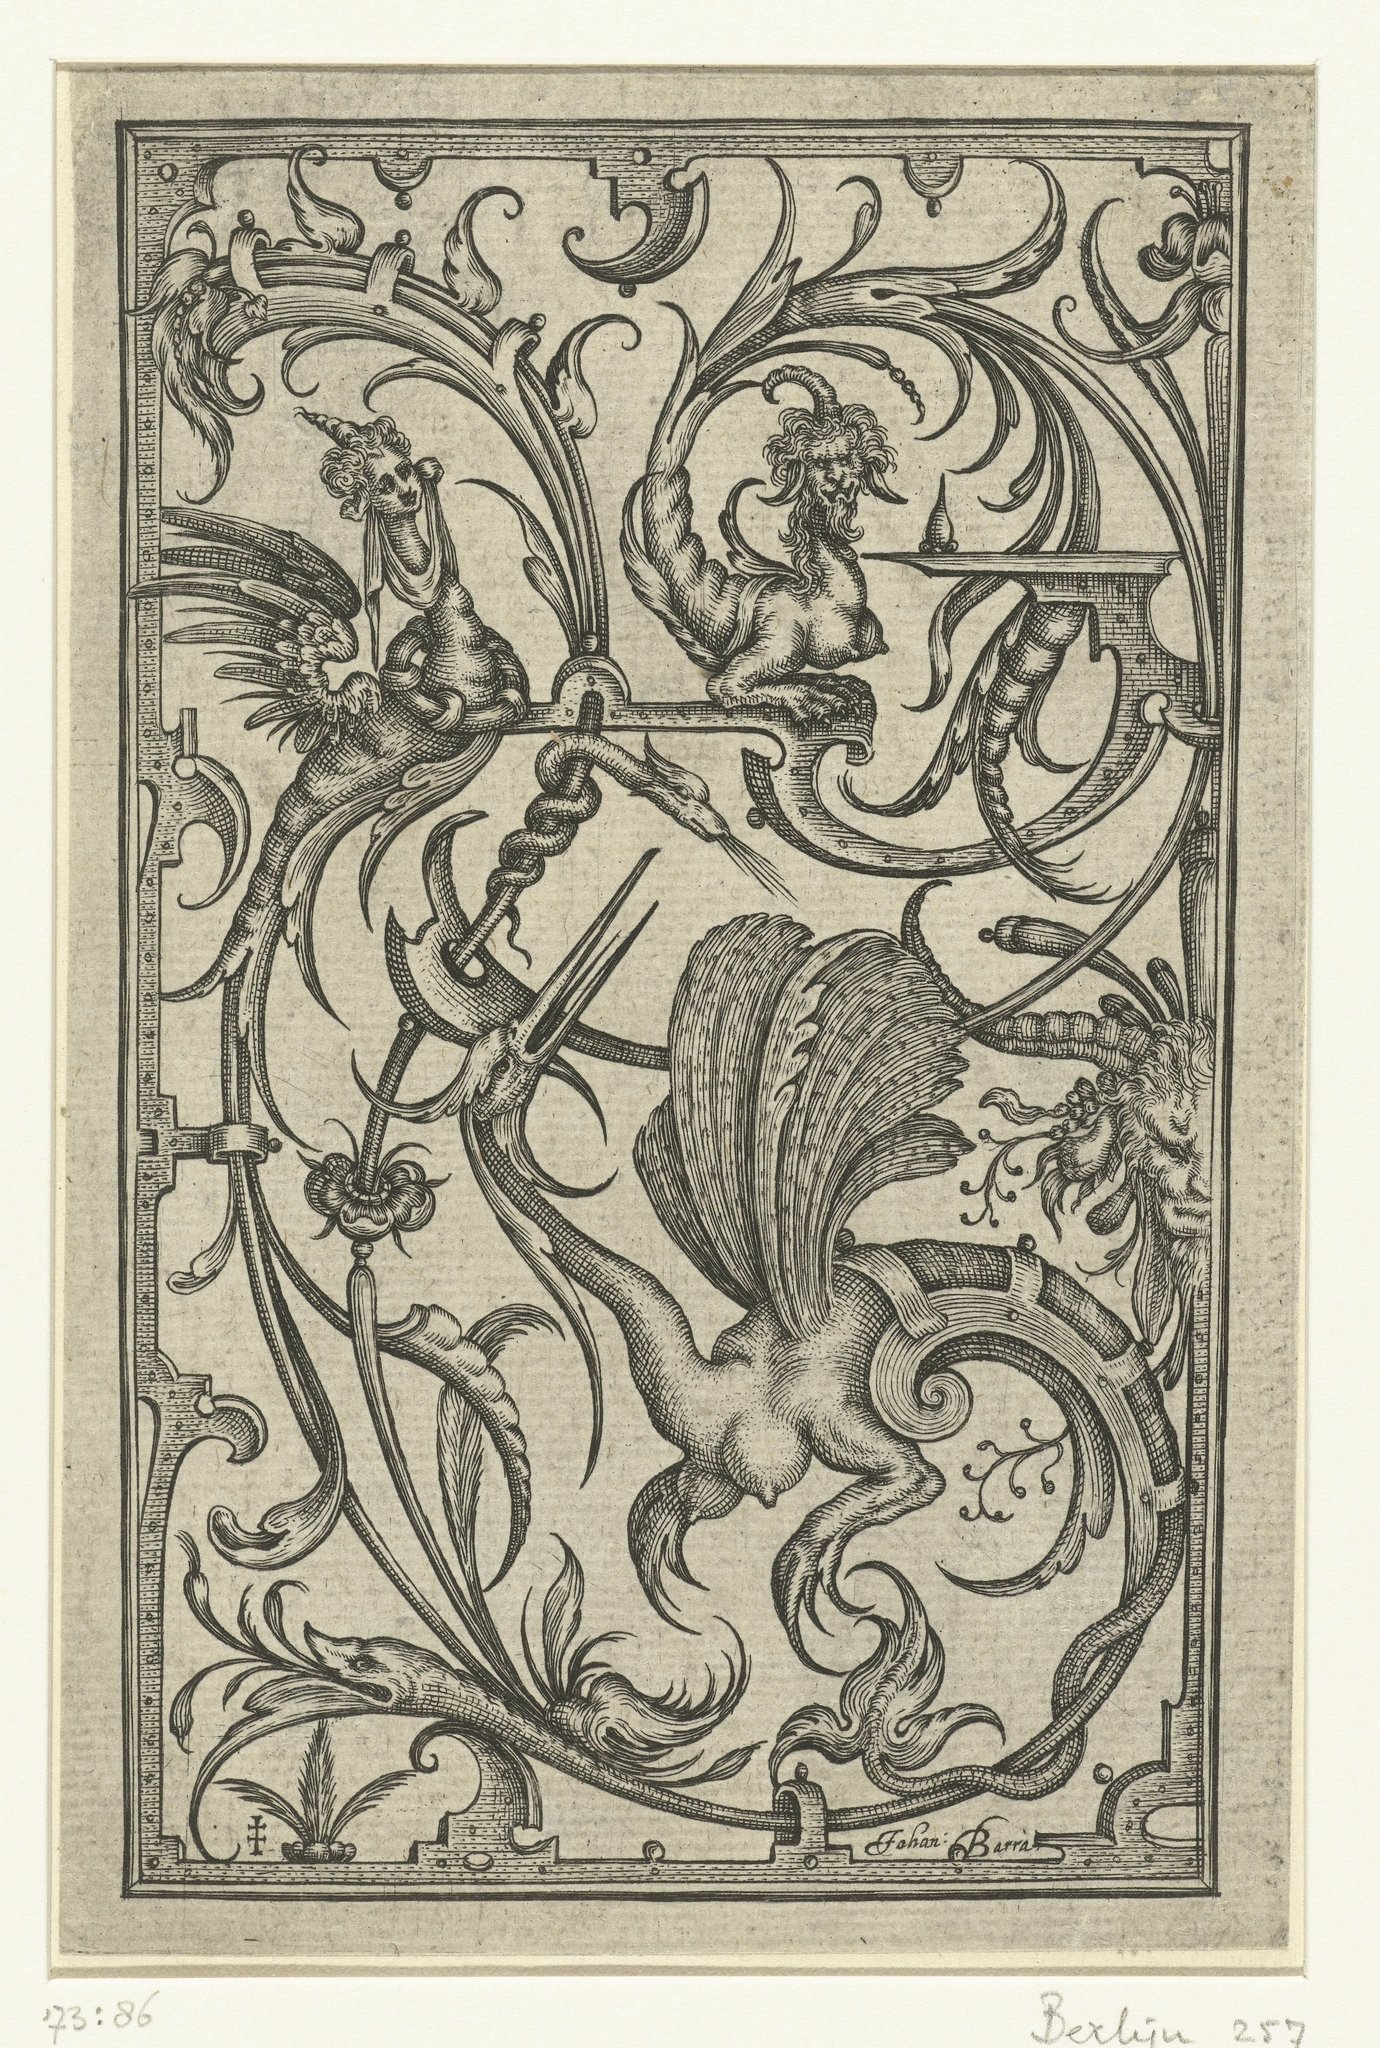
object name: print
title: De Grotesco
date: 1623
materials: paper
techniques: engraving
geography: london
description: Uit serie van 12 bladen met bladranken en grotesken, opgedragen aan George Henriot.